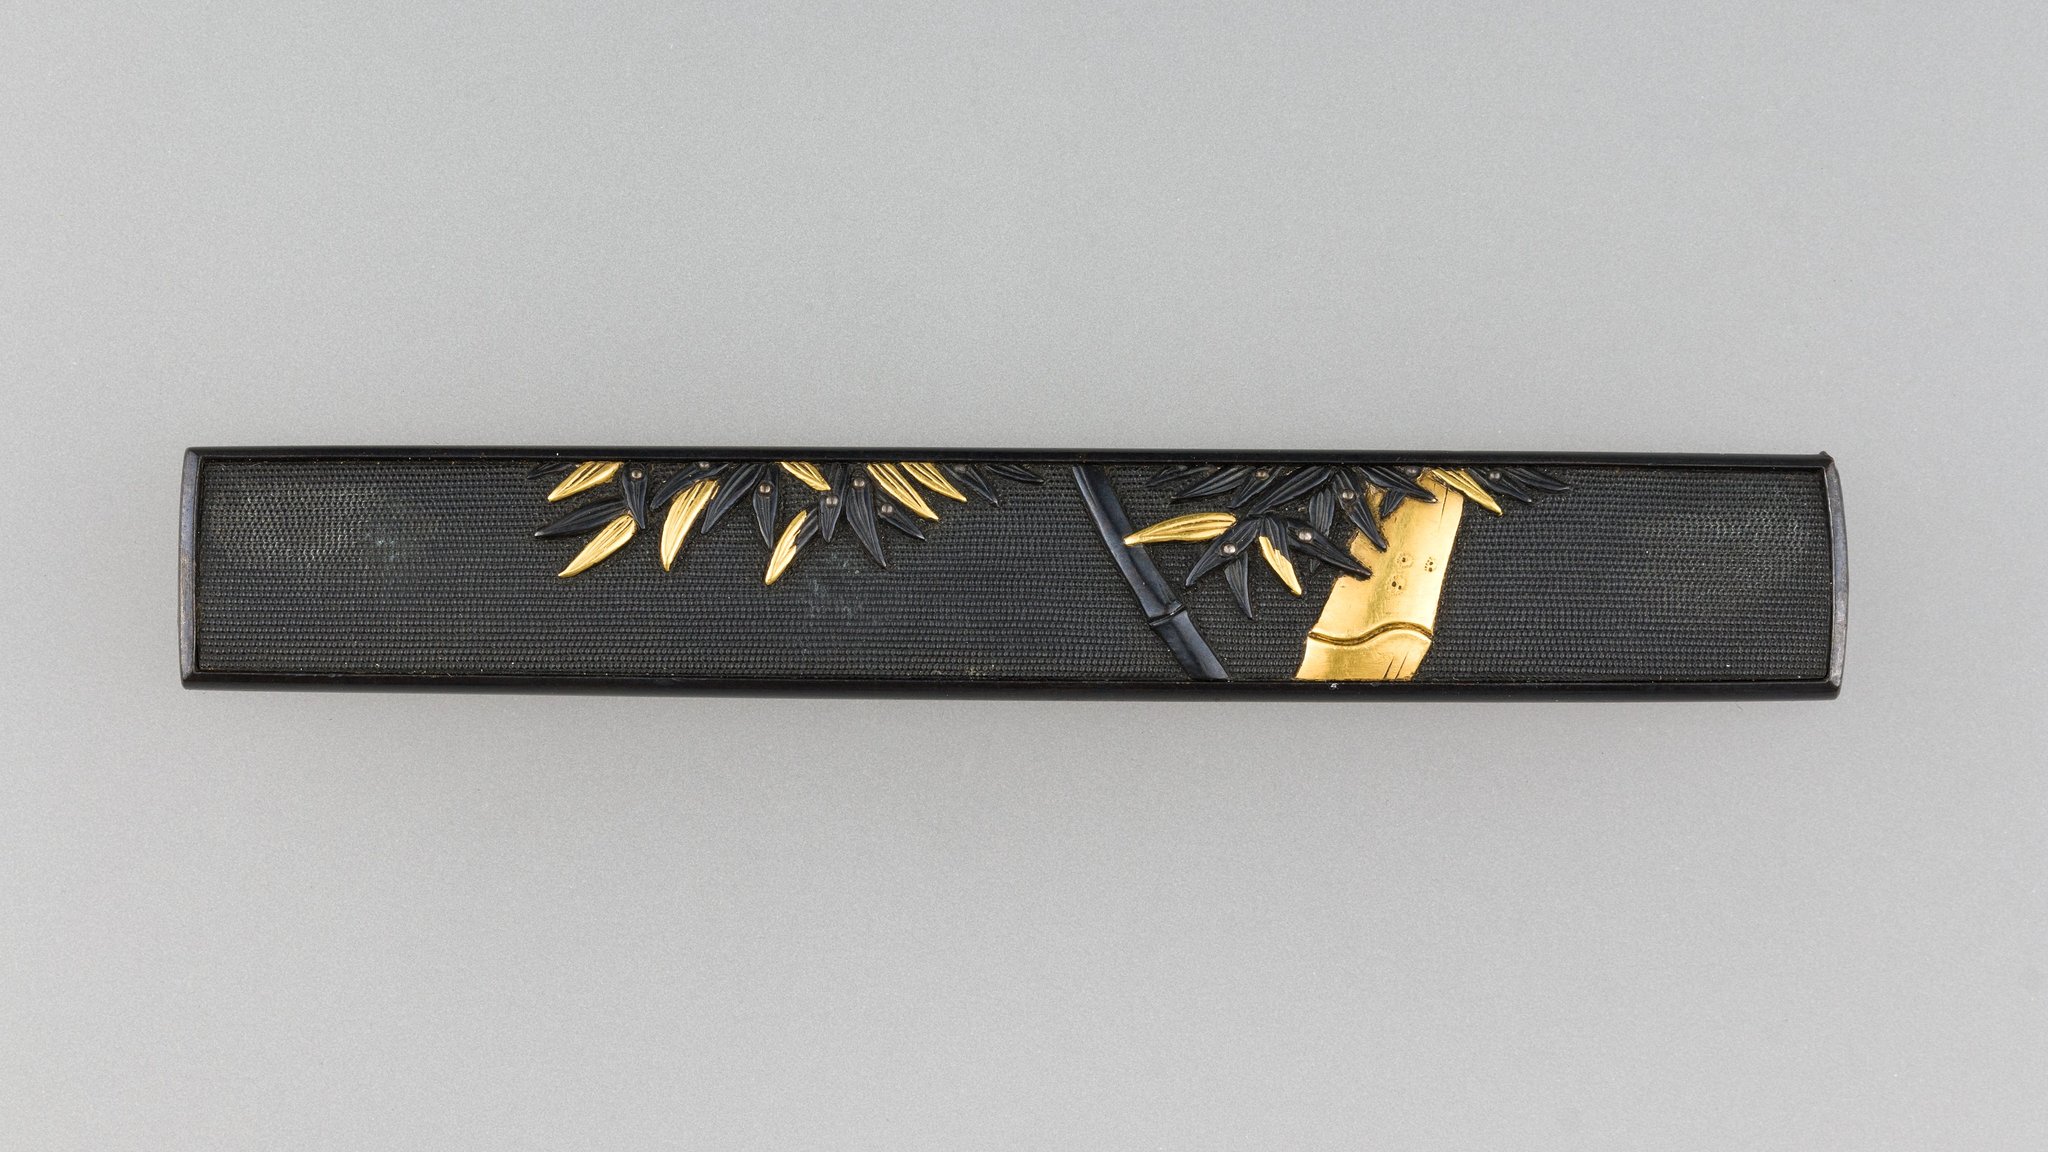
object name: knife handle kozuka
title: Knife Handle (Kozuka)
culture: japanese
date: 1767-1800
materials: gold alloy, gold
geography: japan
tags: bamboo